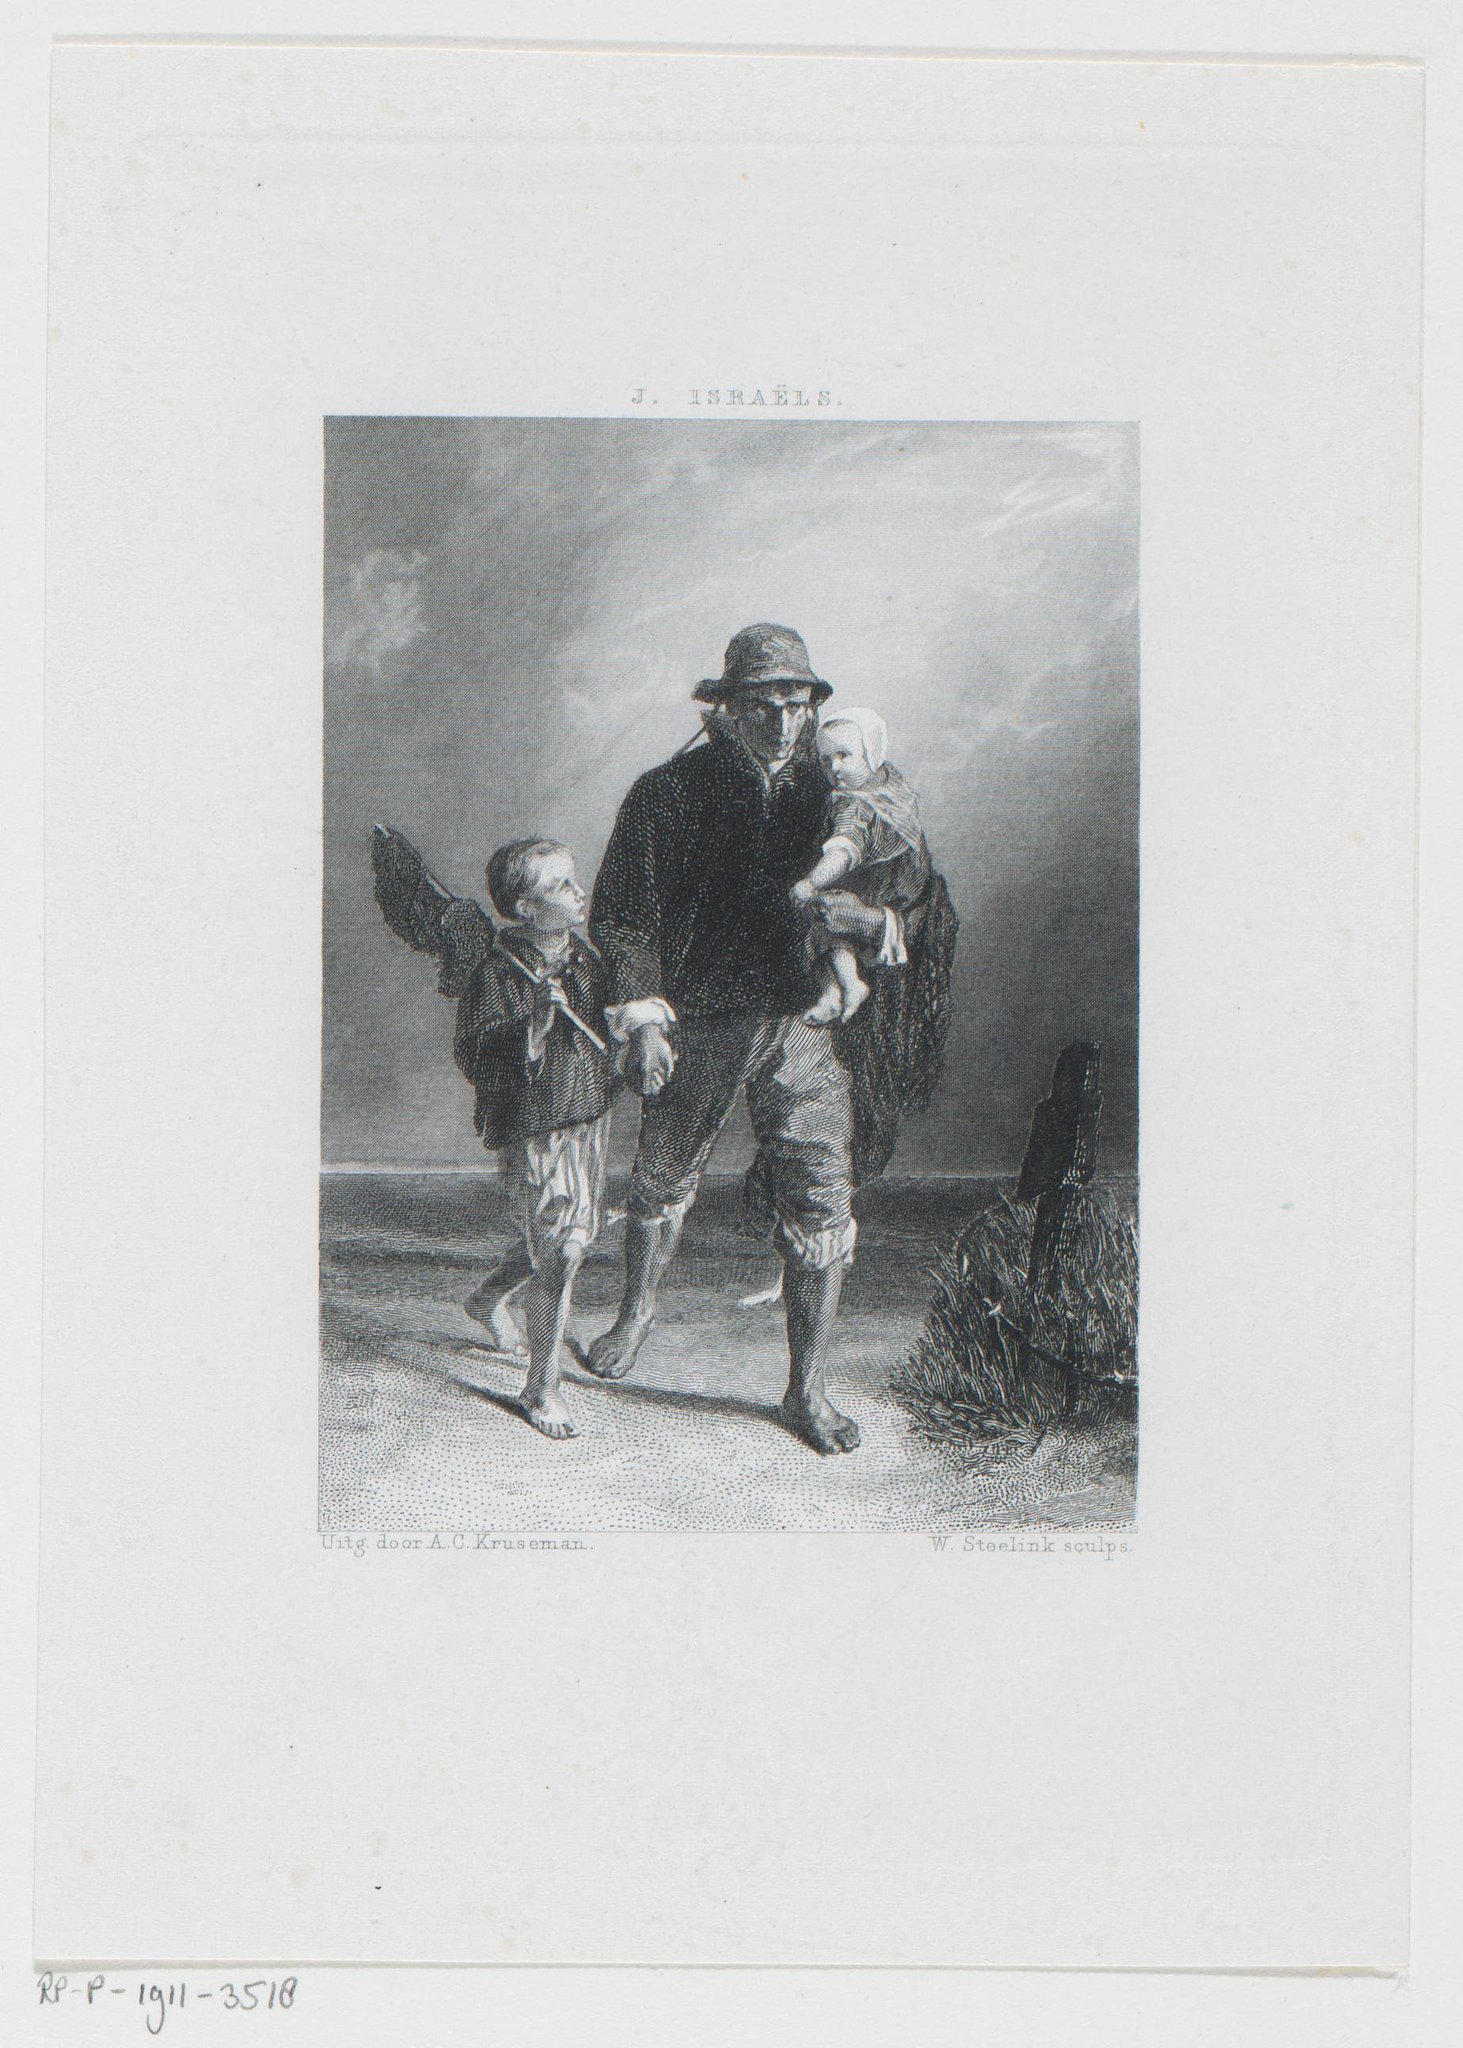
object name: print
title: Passing Mother’s Grave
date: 1858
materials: paper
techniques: etching, engraving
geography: haarlem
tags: grave, tomb, widower, father and child(ren), man and child(ren) (family group)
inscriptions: collector's mark: Lugt 2228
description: Illustratie voor: Aurora. Jaarboekje voor 1858. Haarlem: Arie Cornelis Kruseman, 1858.